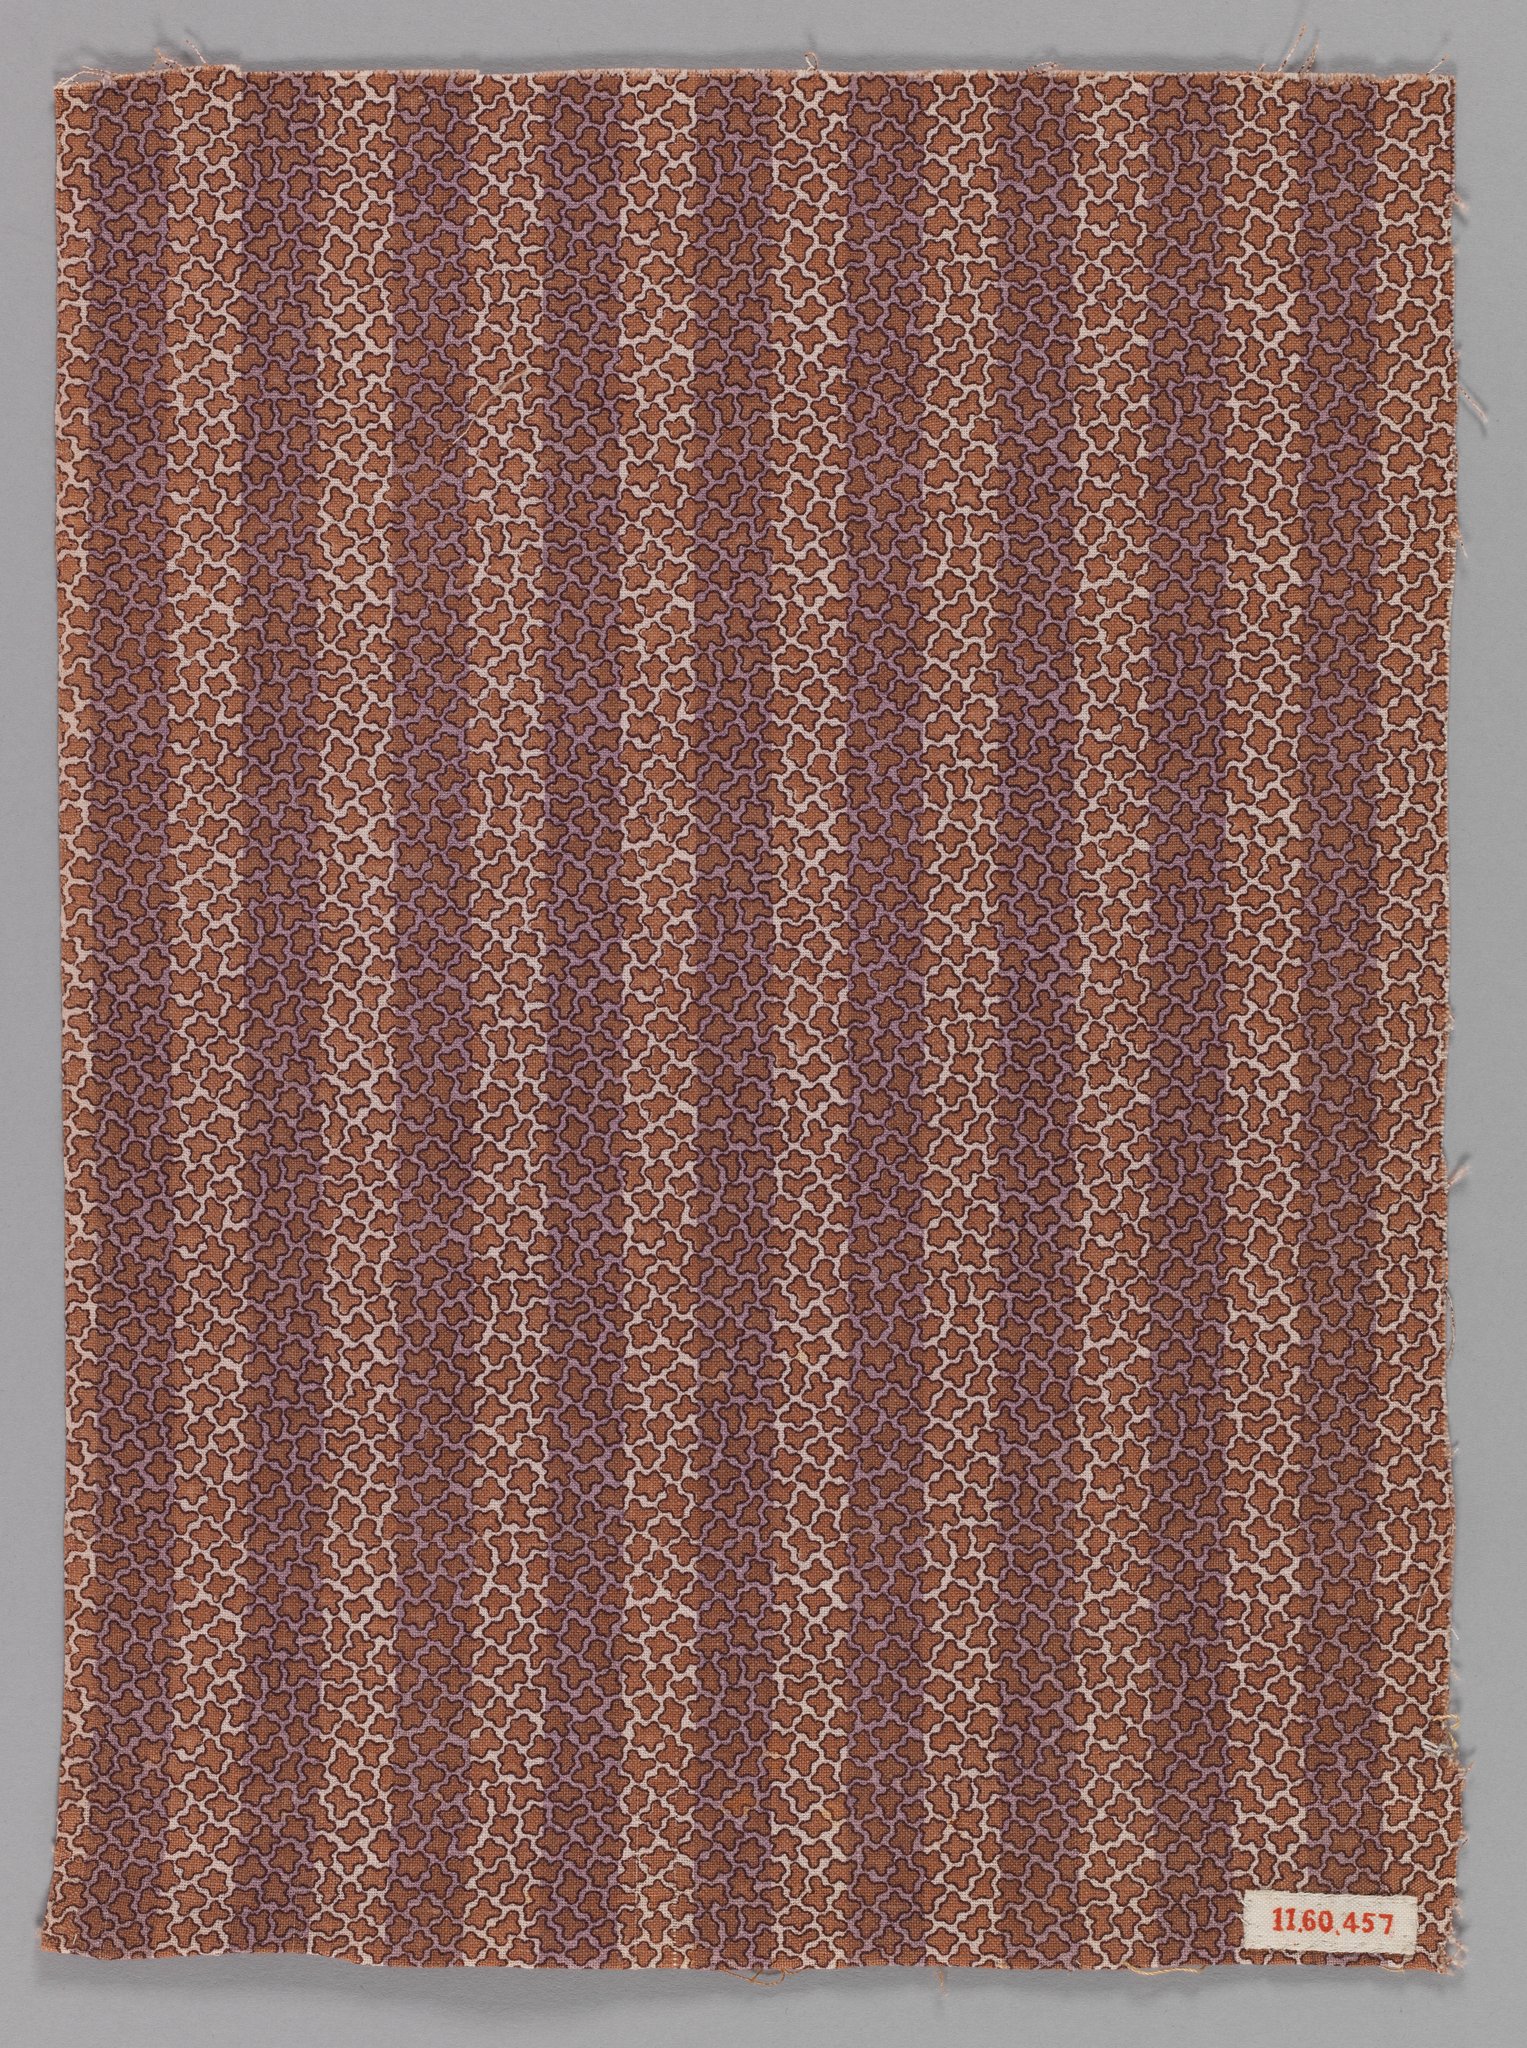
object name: piece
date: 1801-1900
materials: cotton